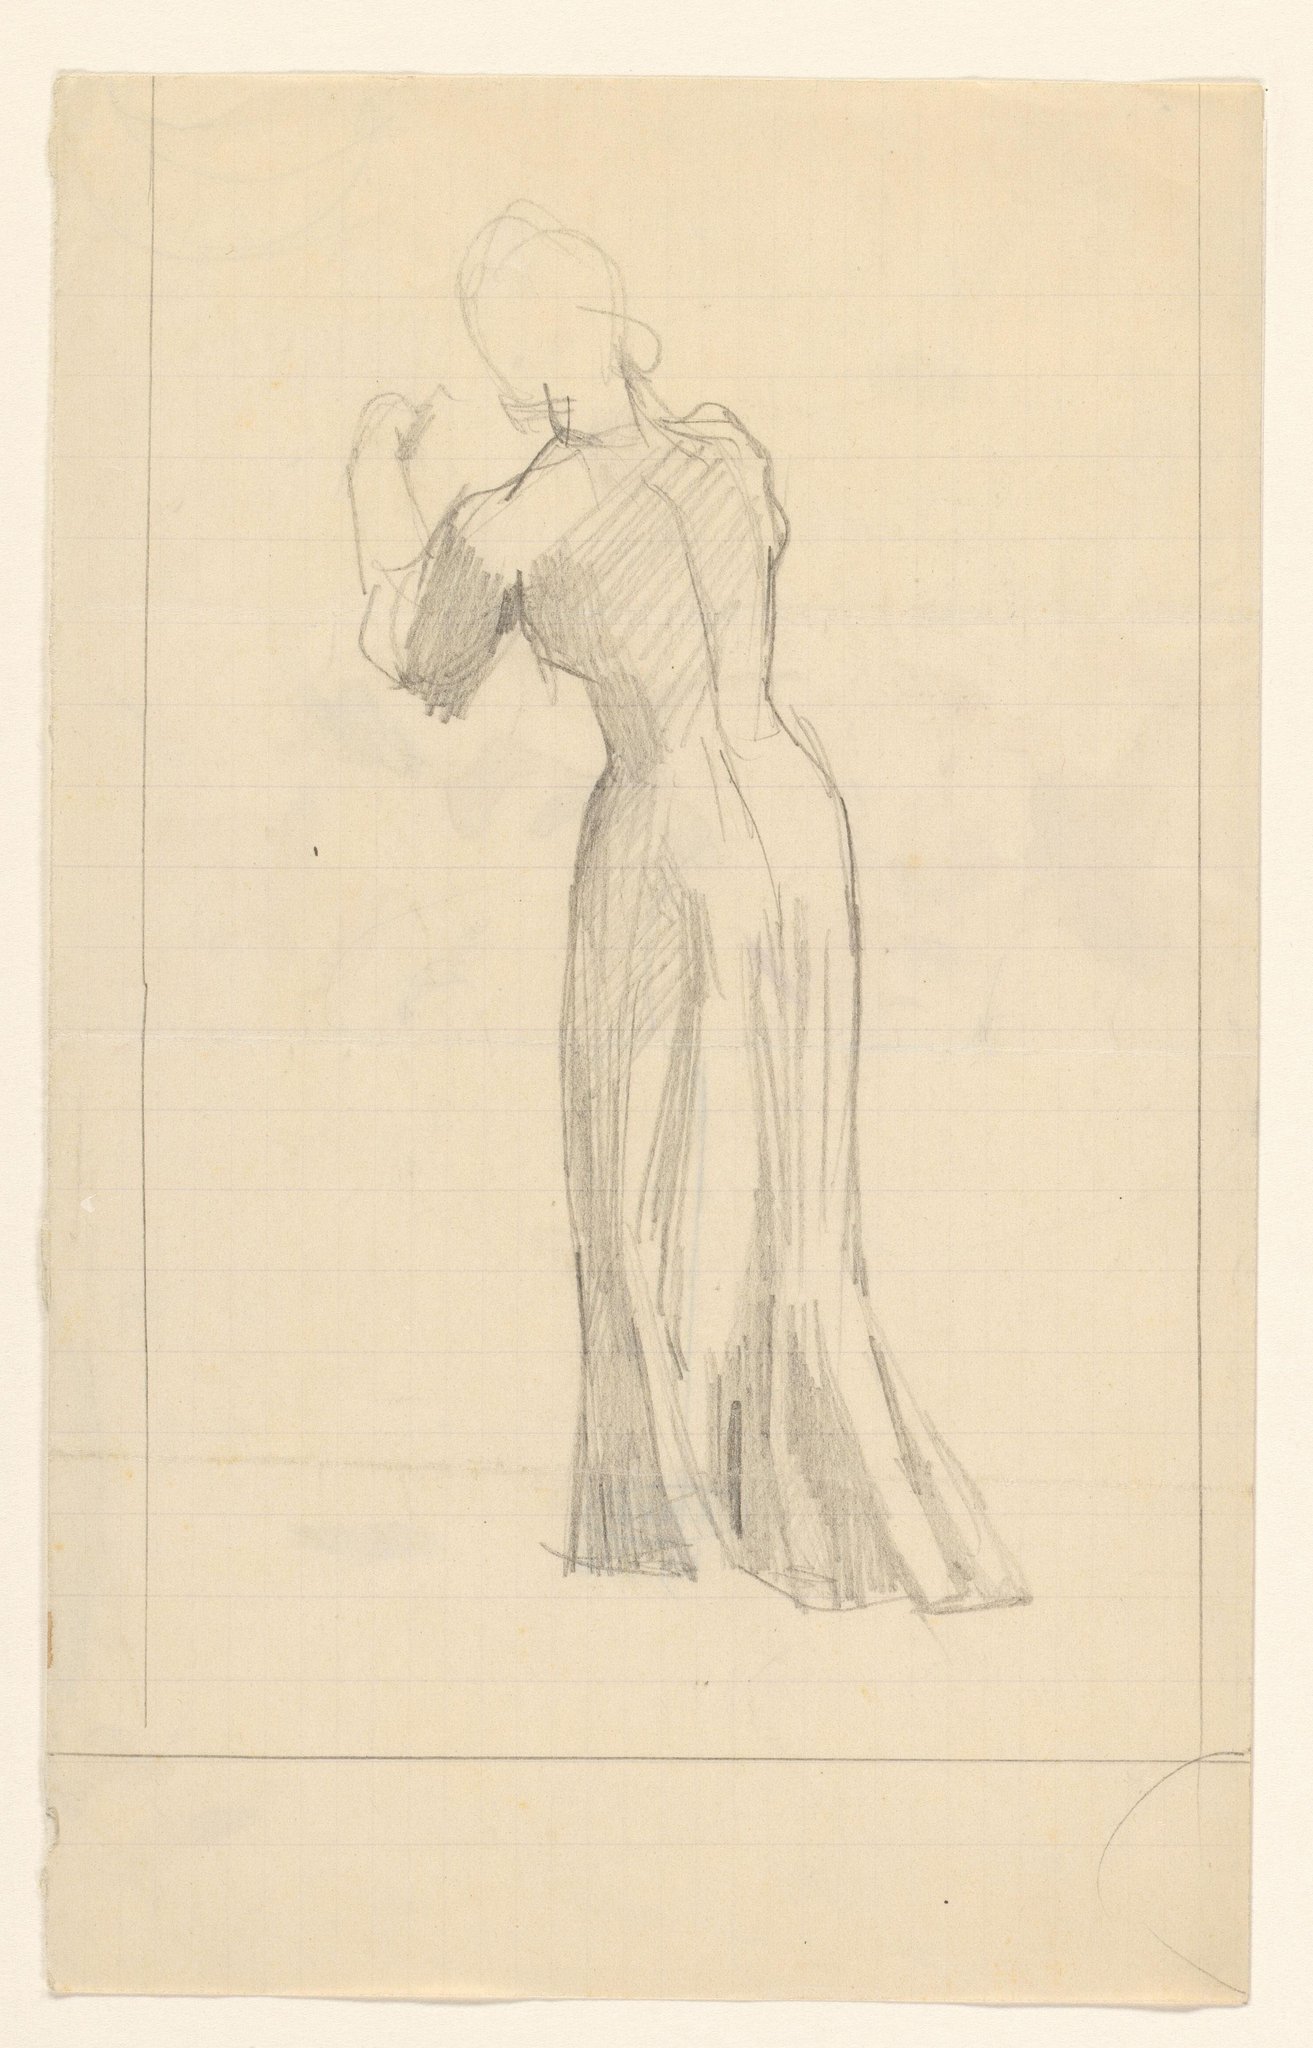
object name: drawing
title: Staande vrouw, van achteren gezien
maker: august allebé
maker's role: draughtsman, print maker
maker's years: 1838-1927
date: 1848-1927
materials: pencil